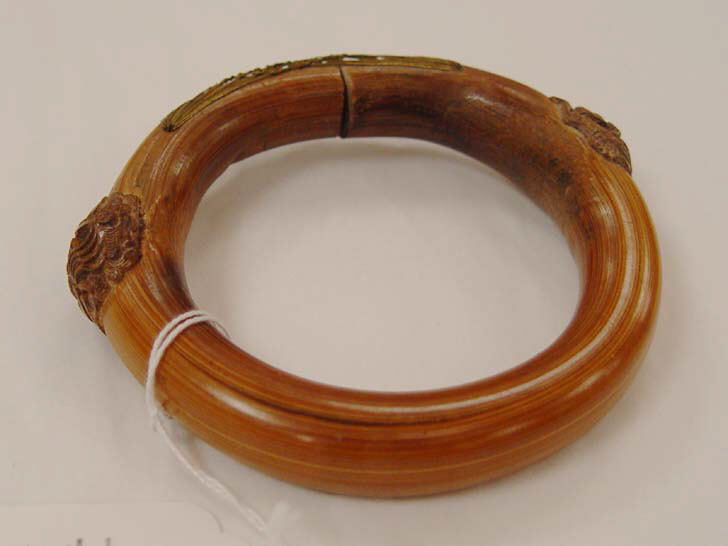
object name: bracelet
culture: chinese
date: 1801-1900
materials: bamboo, metal